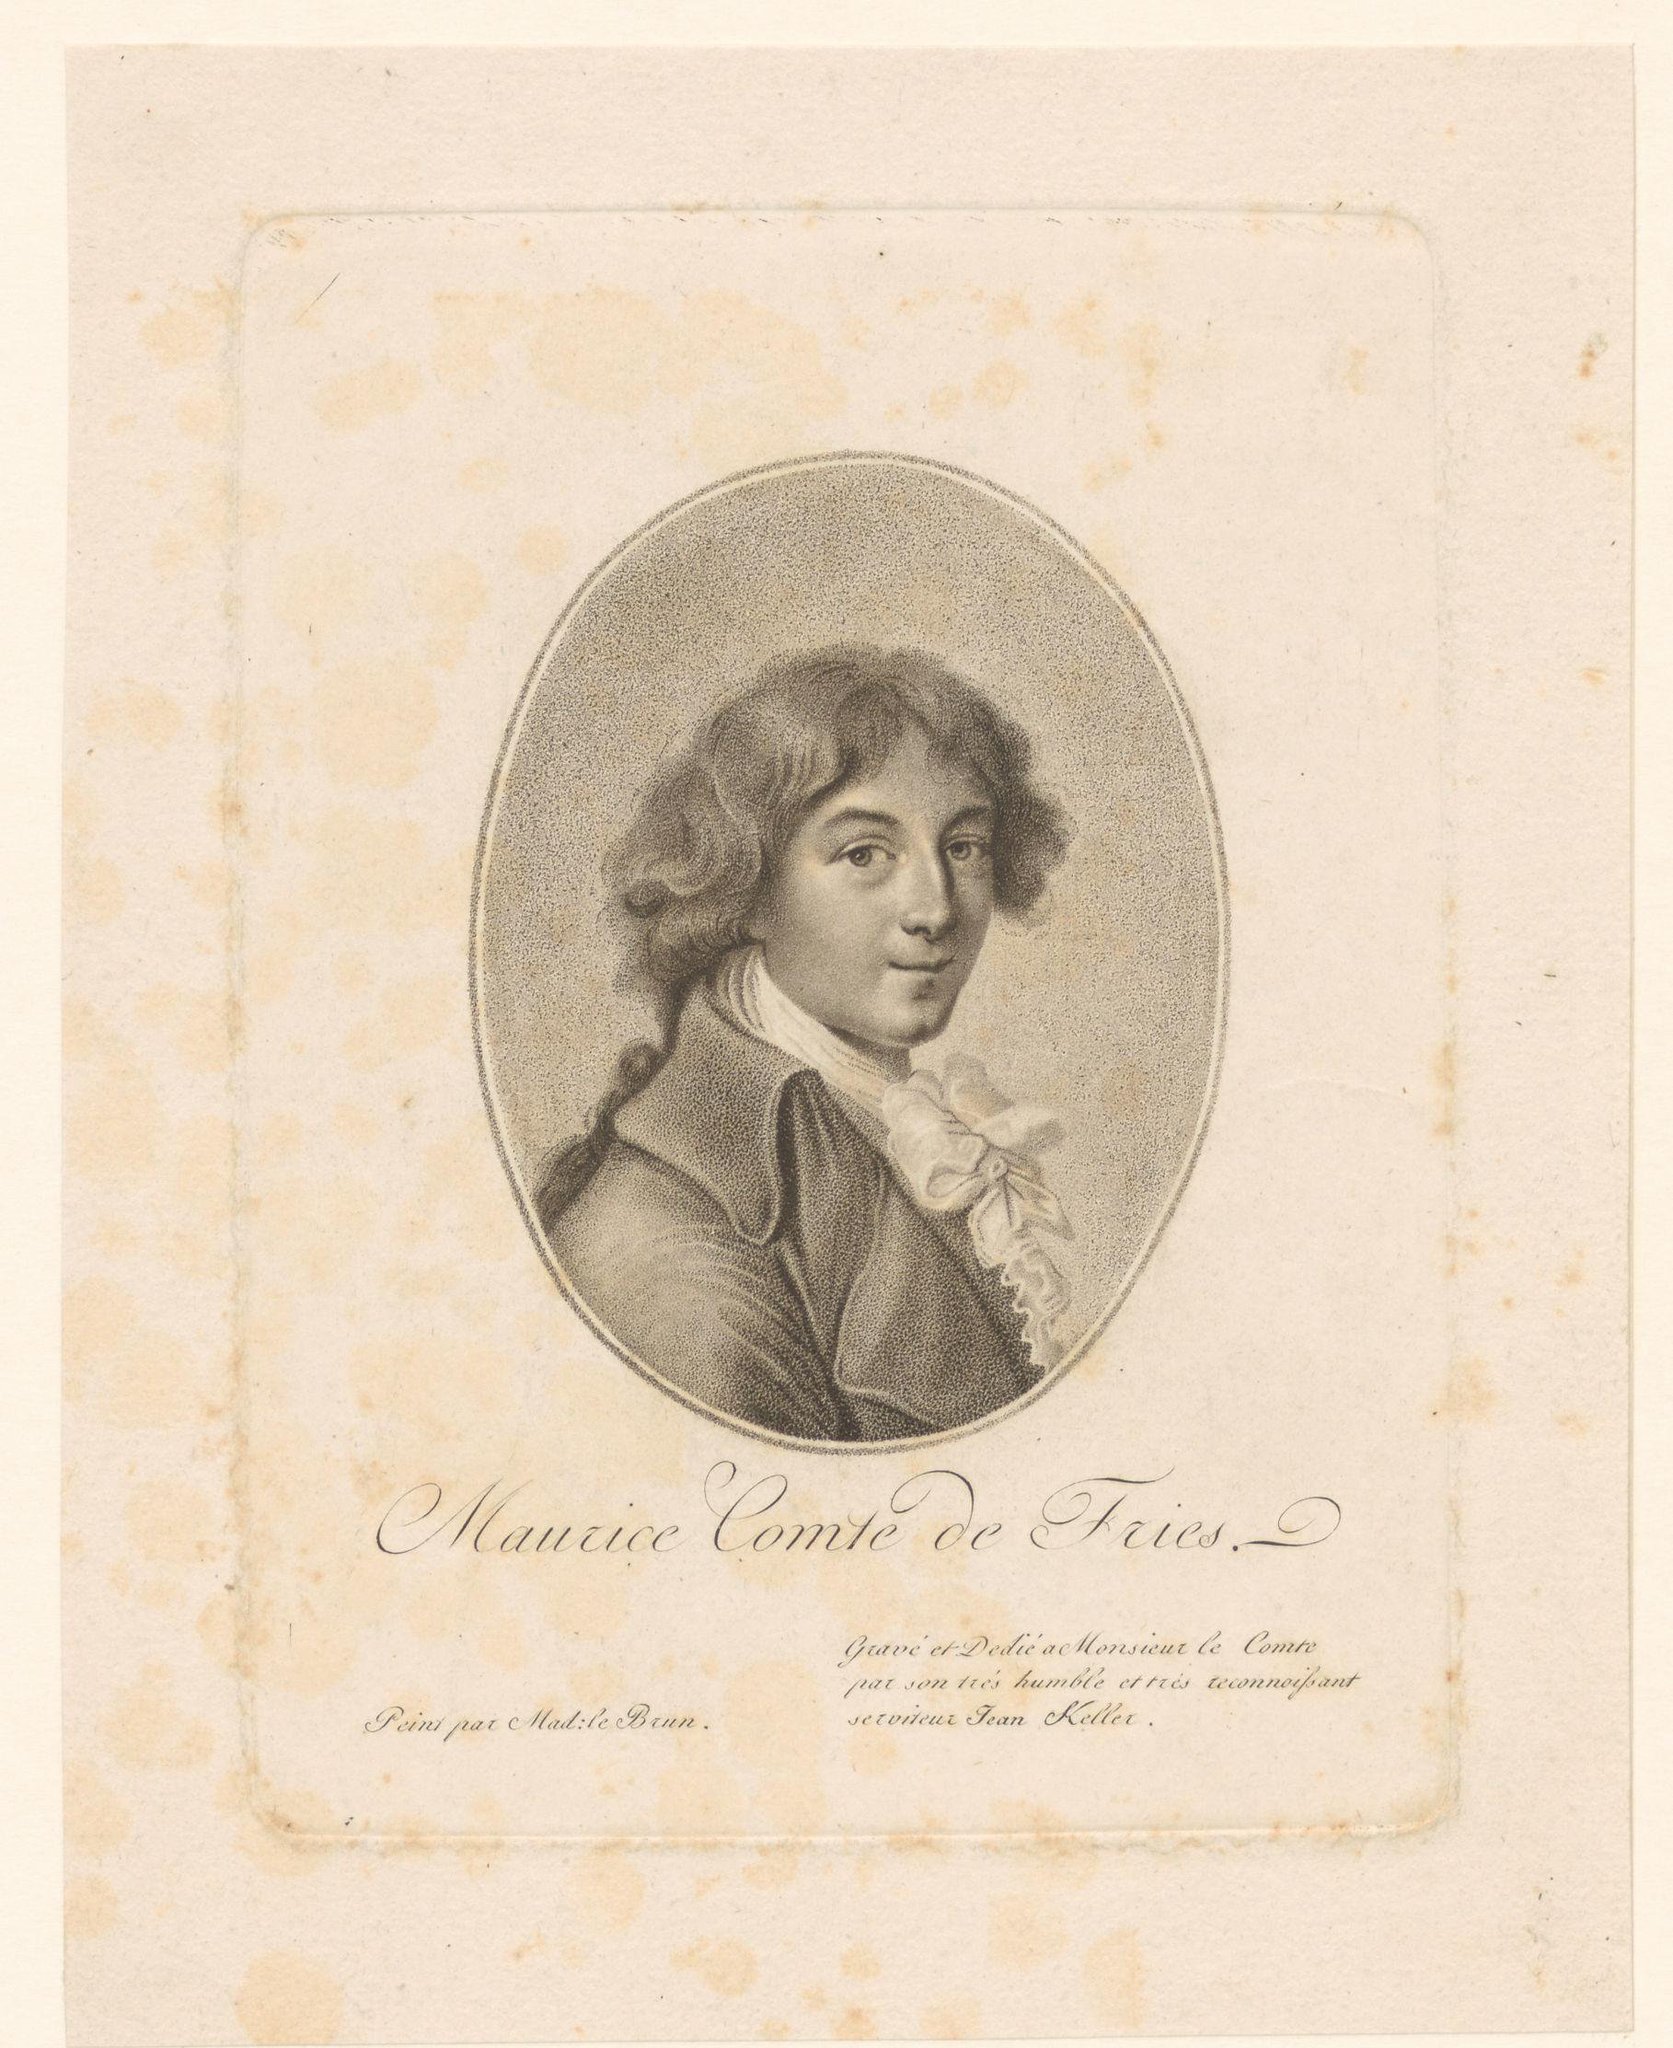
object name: print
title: Portret van Moritz von Fries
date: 1796-1826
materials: paper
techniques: stippling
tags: paris, moritz von fries, banker, historical persons, patron (or client) visiting the artist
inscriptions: collector's mark: Lugt 2228